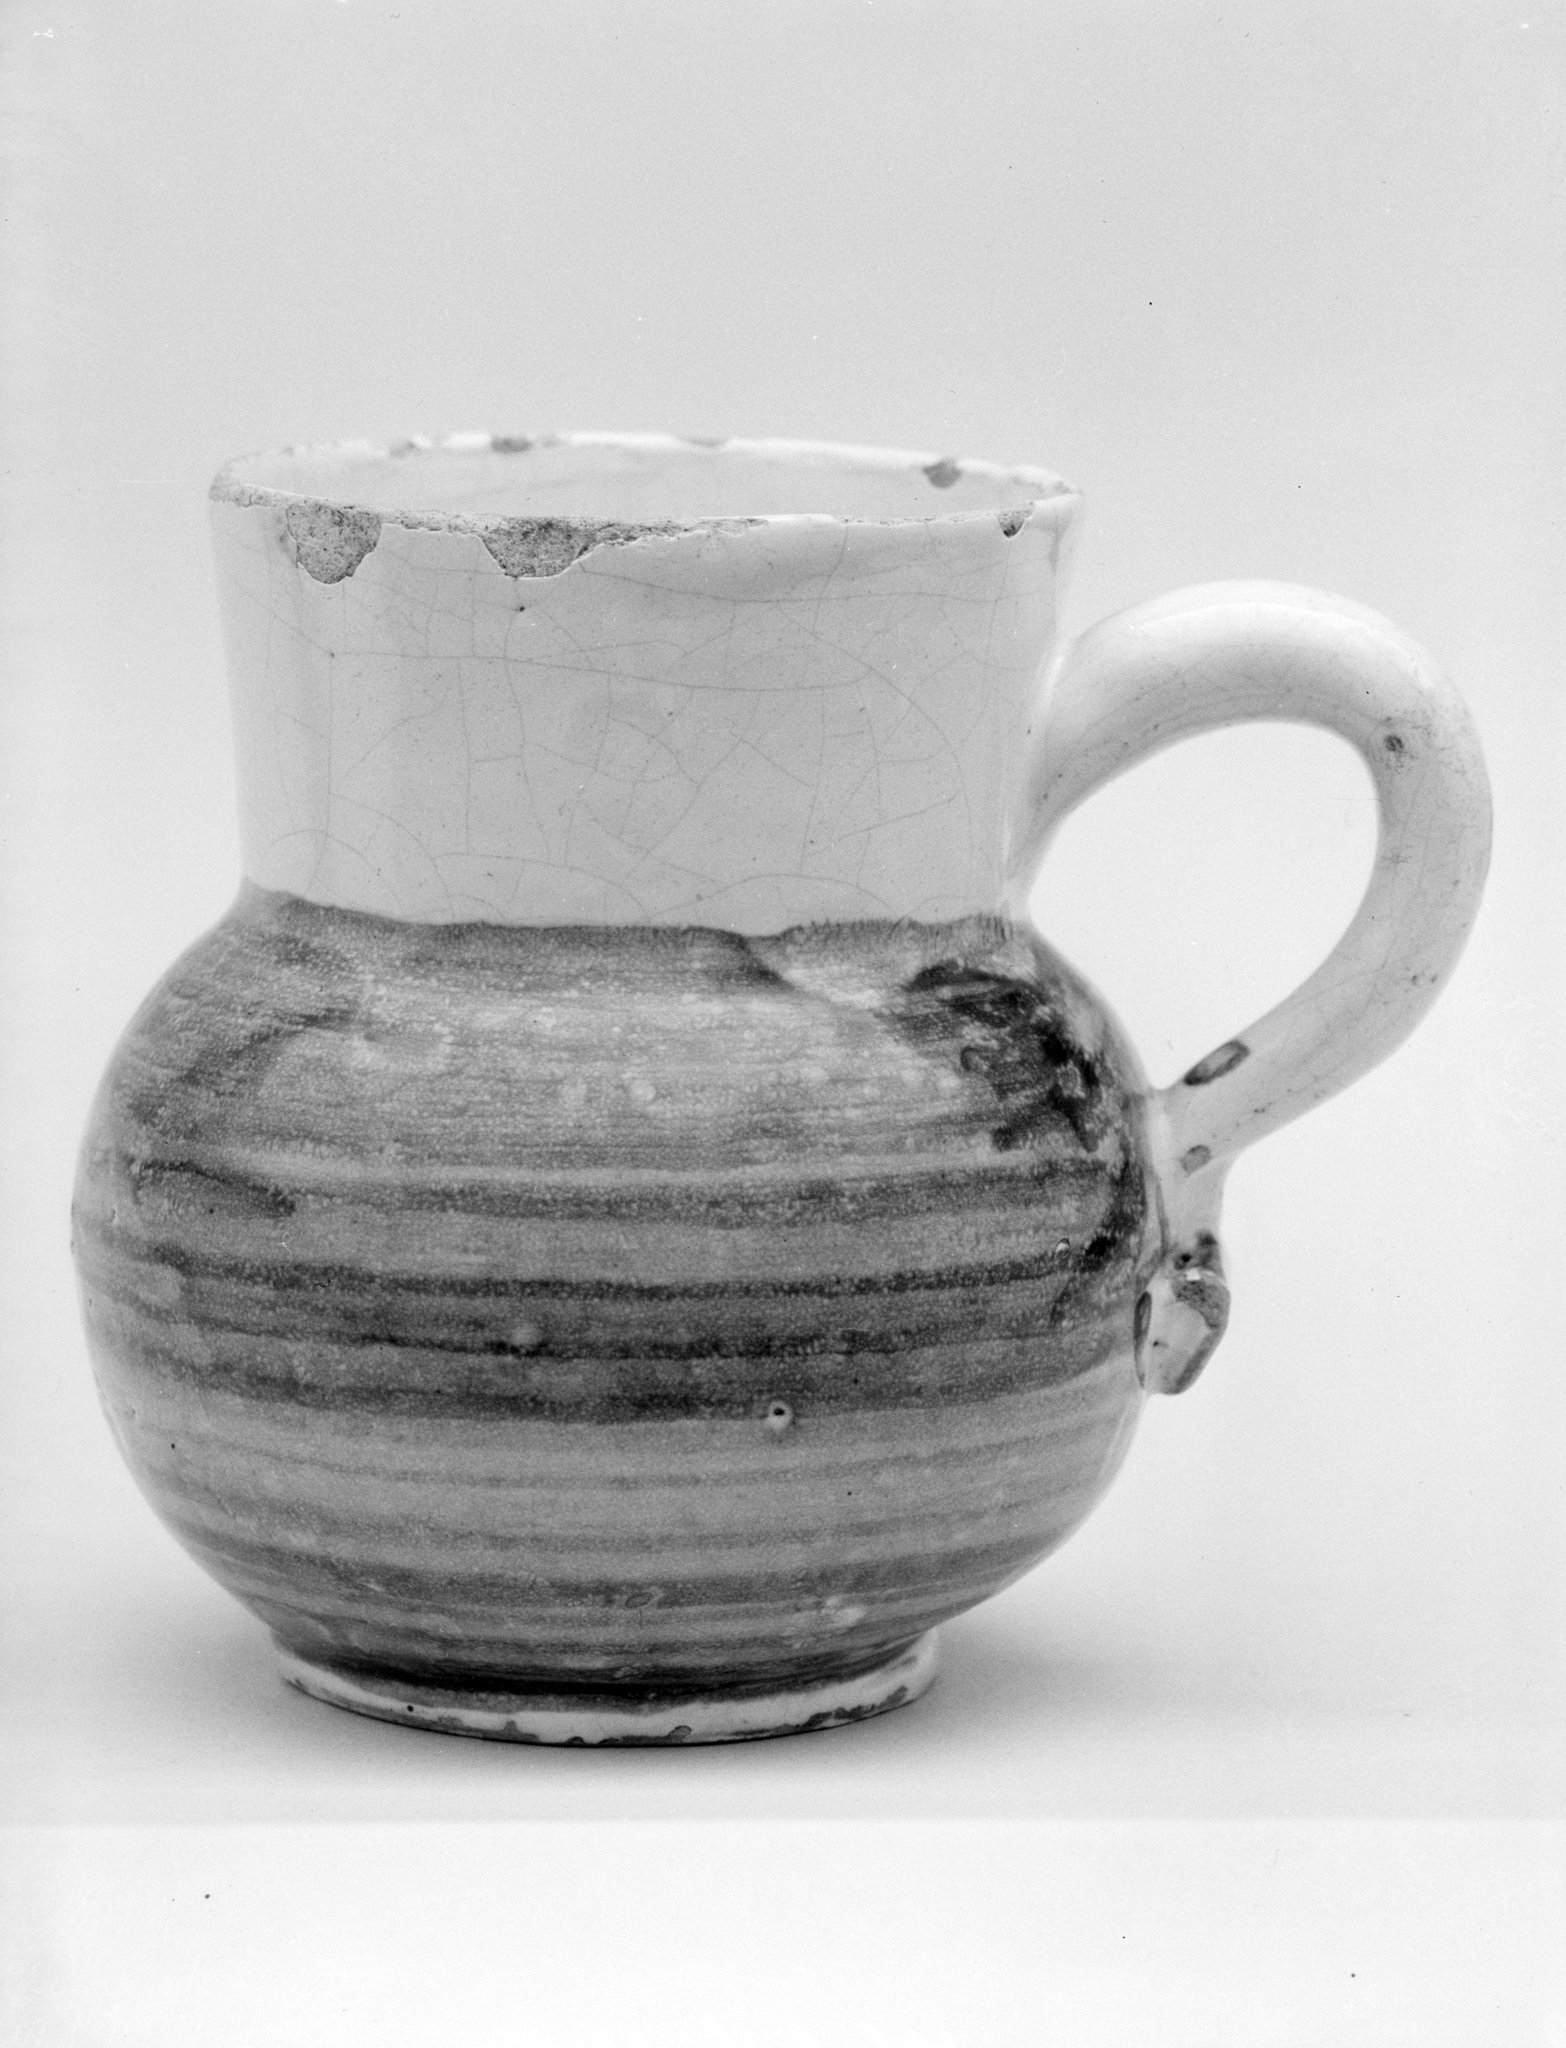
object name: mug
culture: british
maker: lambeth factories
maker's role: maker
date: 1680-1700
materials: earthenware, tin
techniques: enamel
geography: england